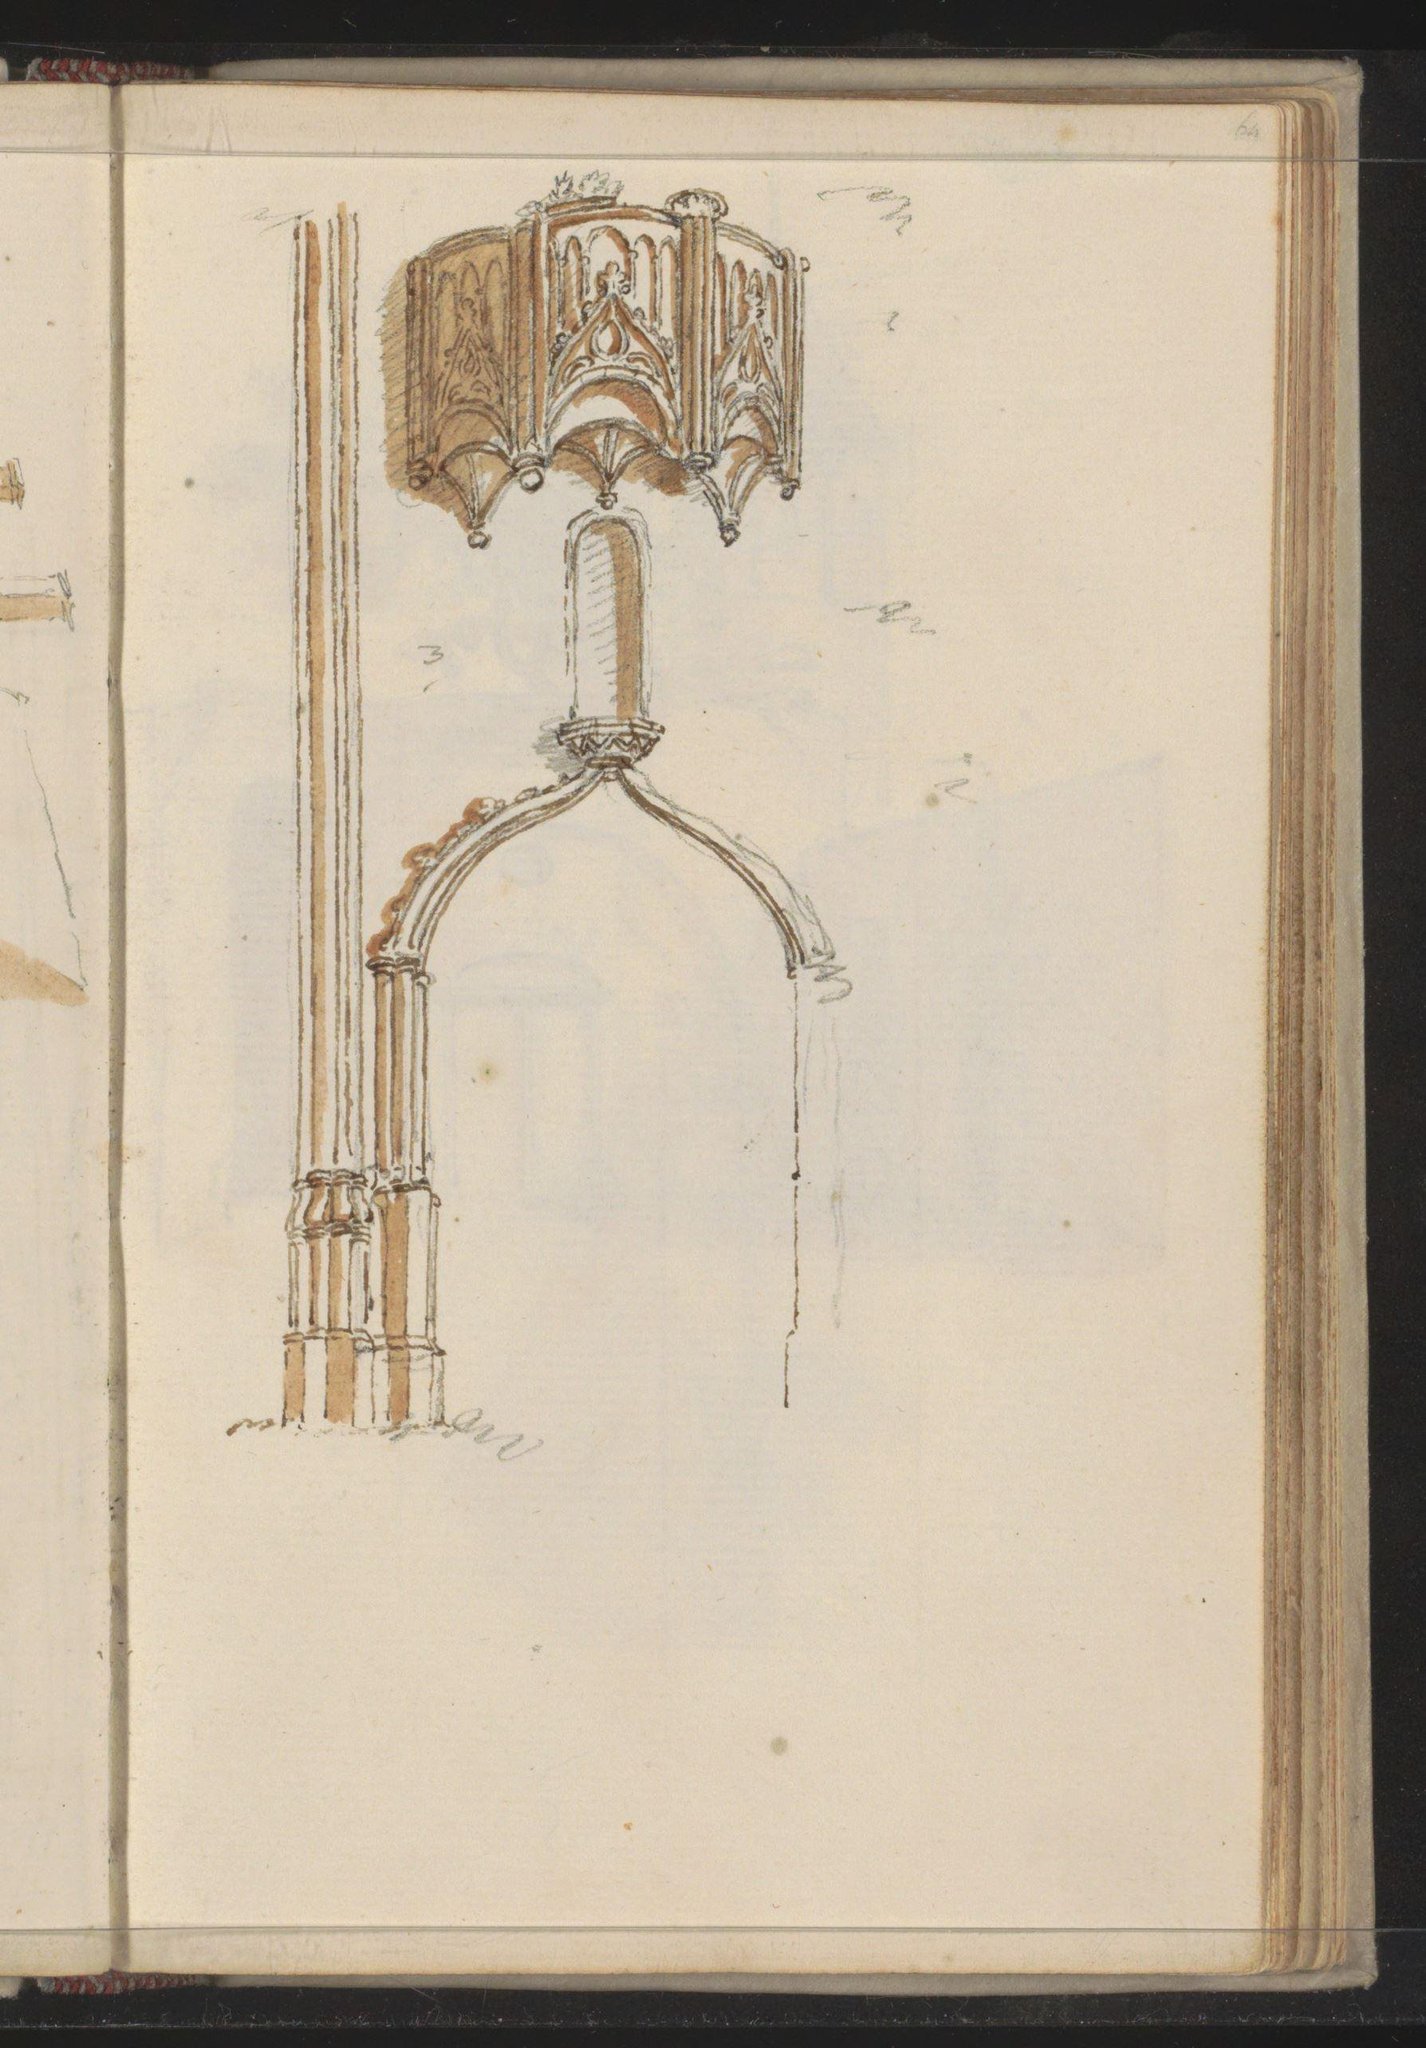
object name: sketchbook leaf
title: Gotisch portaal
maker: johannes huibert prins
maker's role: draughtsman, painter, print maker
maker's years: 1757-1806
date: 1783-1797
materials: ink, paper, pencil, watercolor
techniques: brush, pen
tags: parts of church exterior and annexes: portal, ornament ~ tracery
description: Boven het portaal ornamenten met maaswerk. Pagina 64 uit een schetsboek met 175 pagina's.